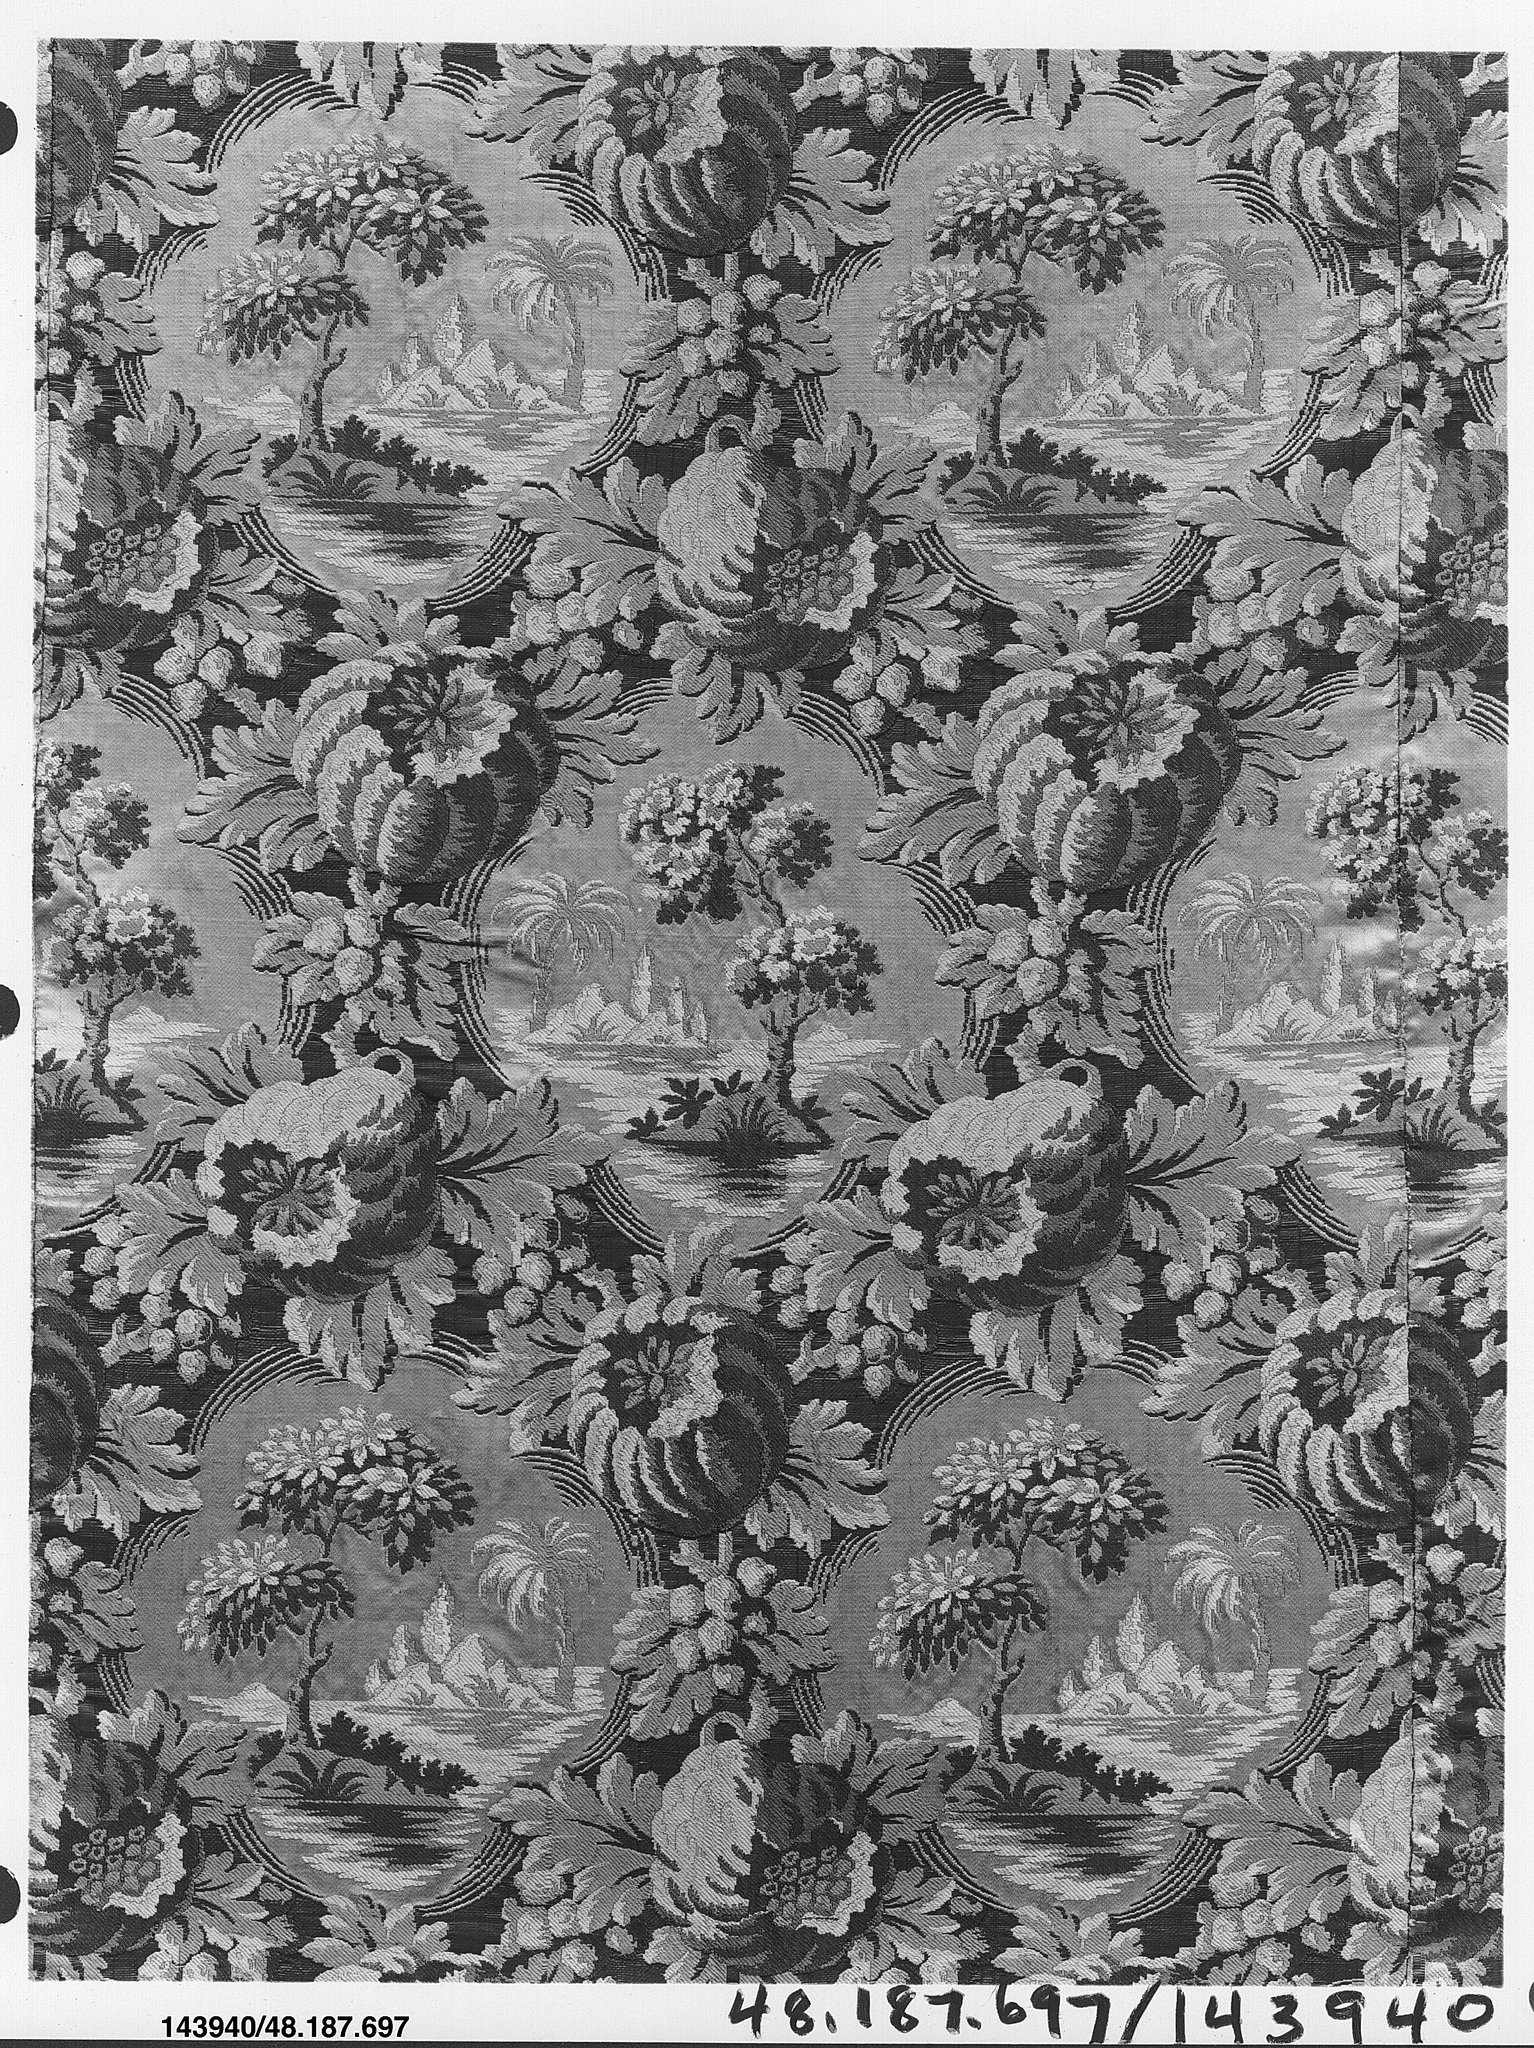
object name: piece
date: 1726-1750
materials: silk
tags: flowers